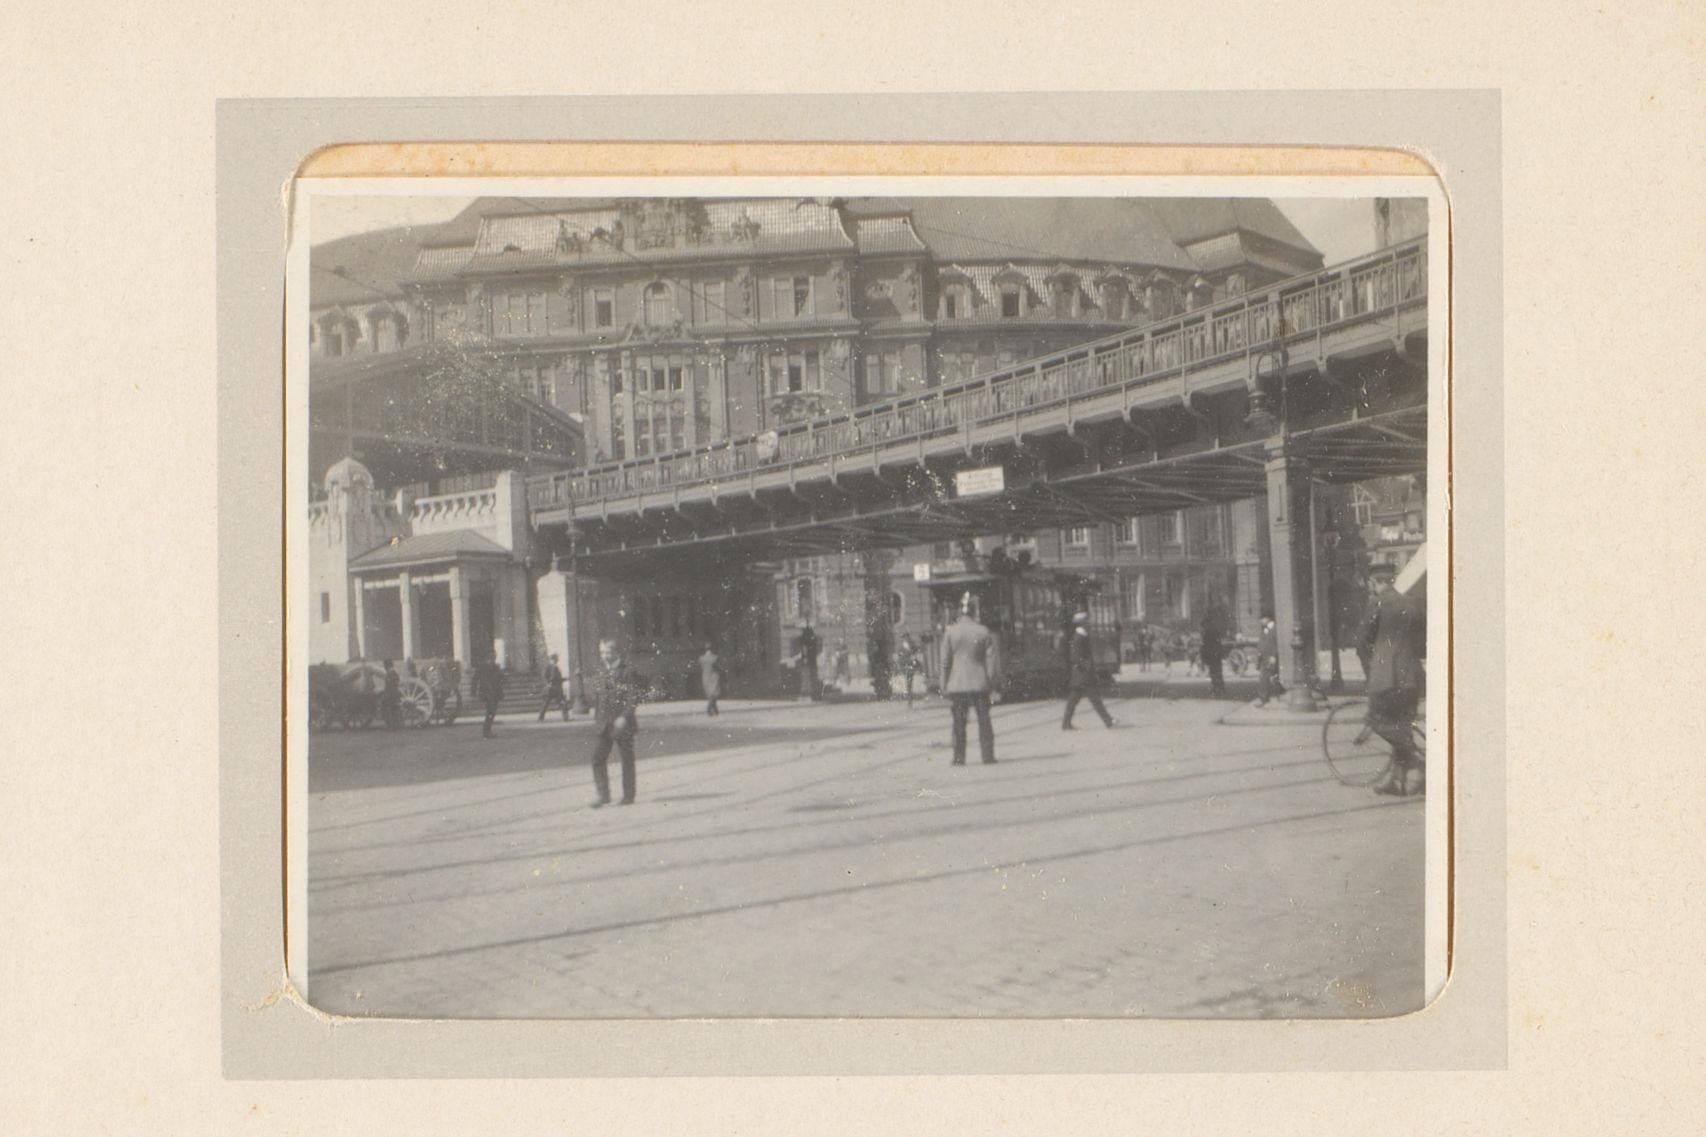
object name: photograph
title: Straatgezicht met tram en verhoogde spoorlijn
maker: liesbeth overhoff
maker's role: fotograaf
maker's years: 1895-1969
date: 1911-1912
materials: paper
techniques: gelatin silver print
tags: tram, city-view in general; 'veduta', station; shelter (railway, tramway), street